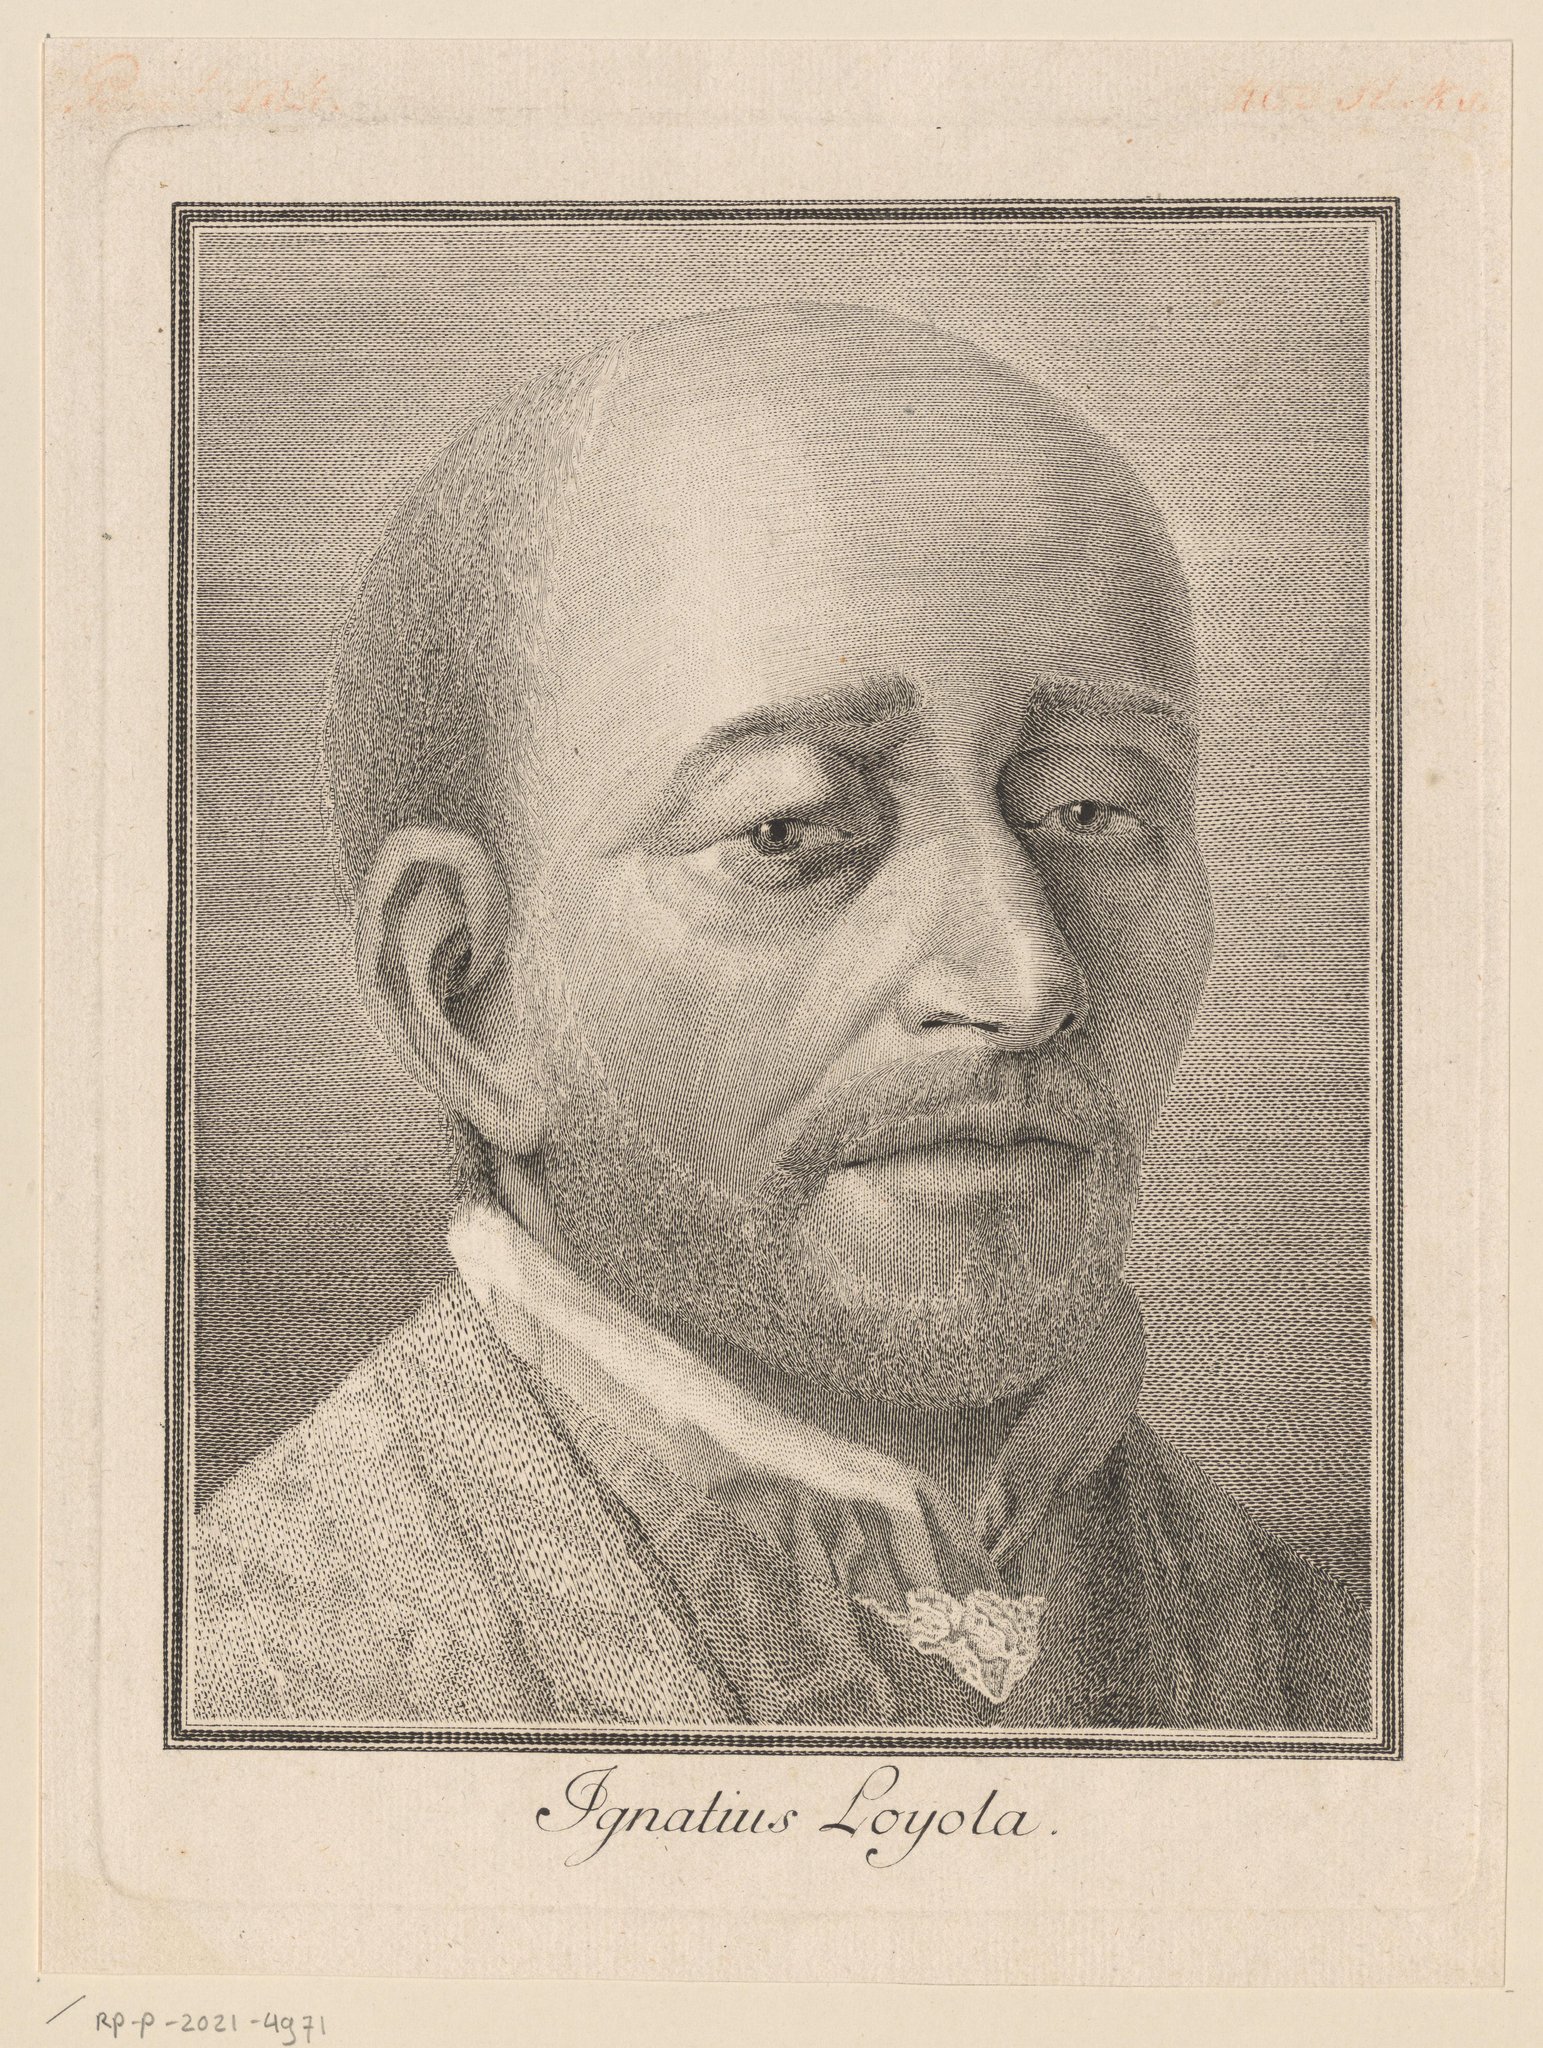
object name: print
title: Portret van Ignatius van Loyola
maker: Anonymous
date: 1650-1750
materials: paper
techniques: engraving, etching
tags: rome, clergyman, historical persons, the founder of the jesuit order, ignatius of loyola; possible attributes: book (with 'ad majorem dei gloriam'), demon, dragon under feet, flames, flaming heart, globe, ihs monogram, skull (with crown), tears in eyes, torch